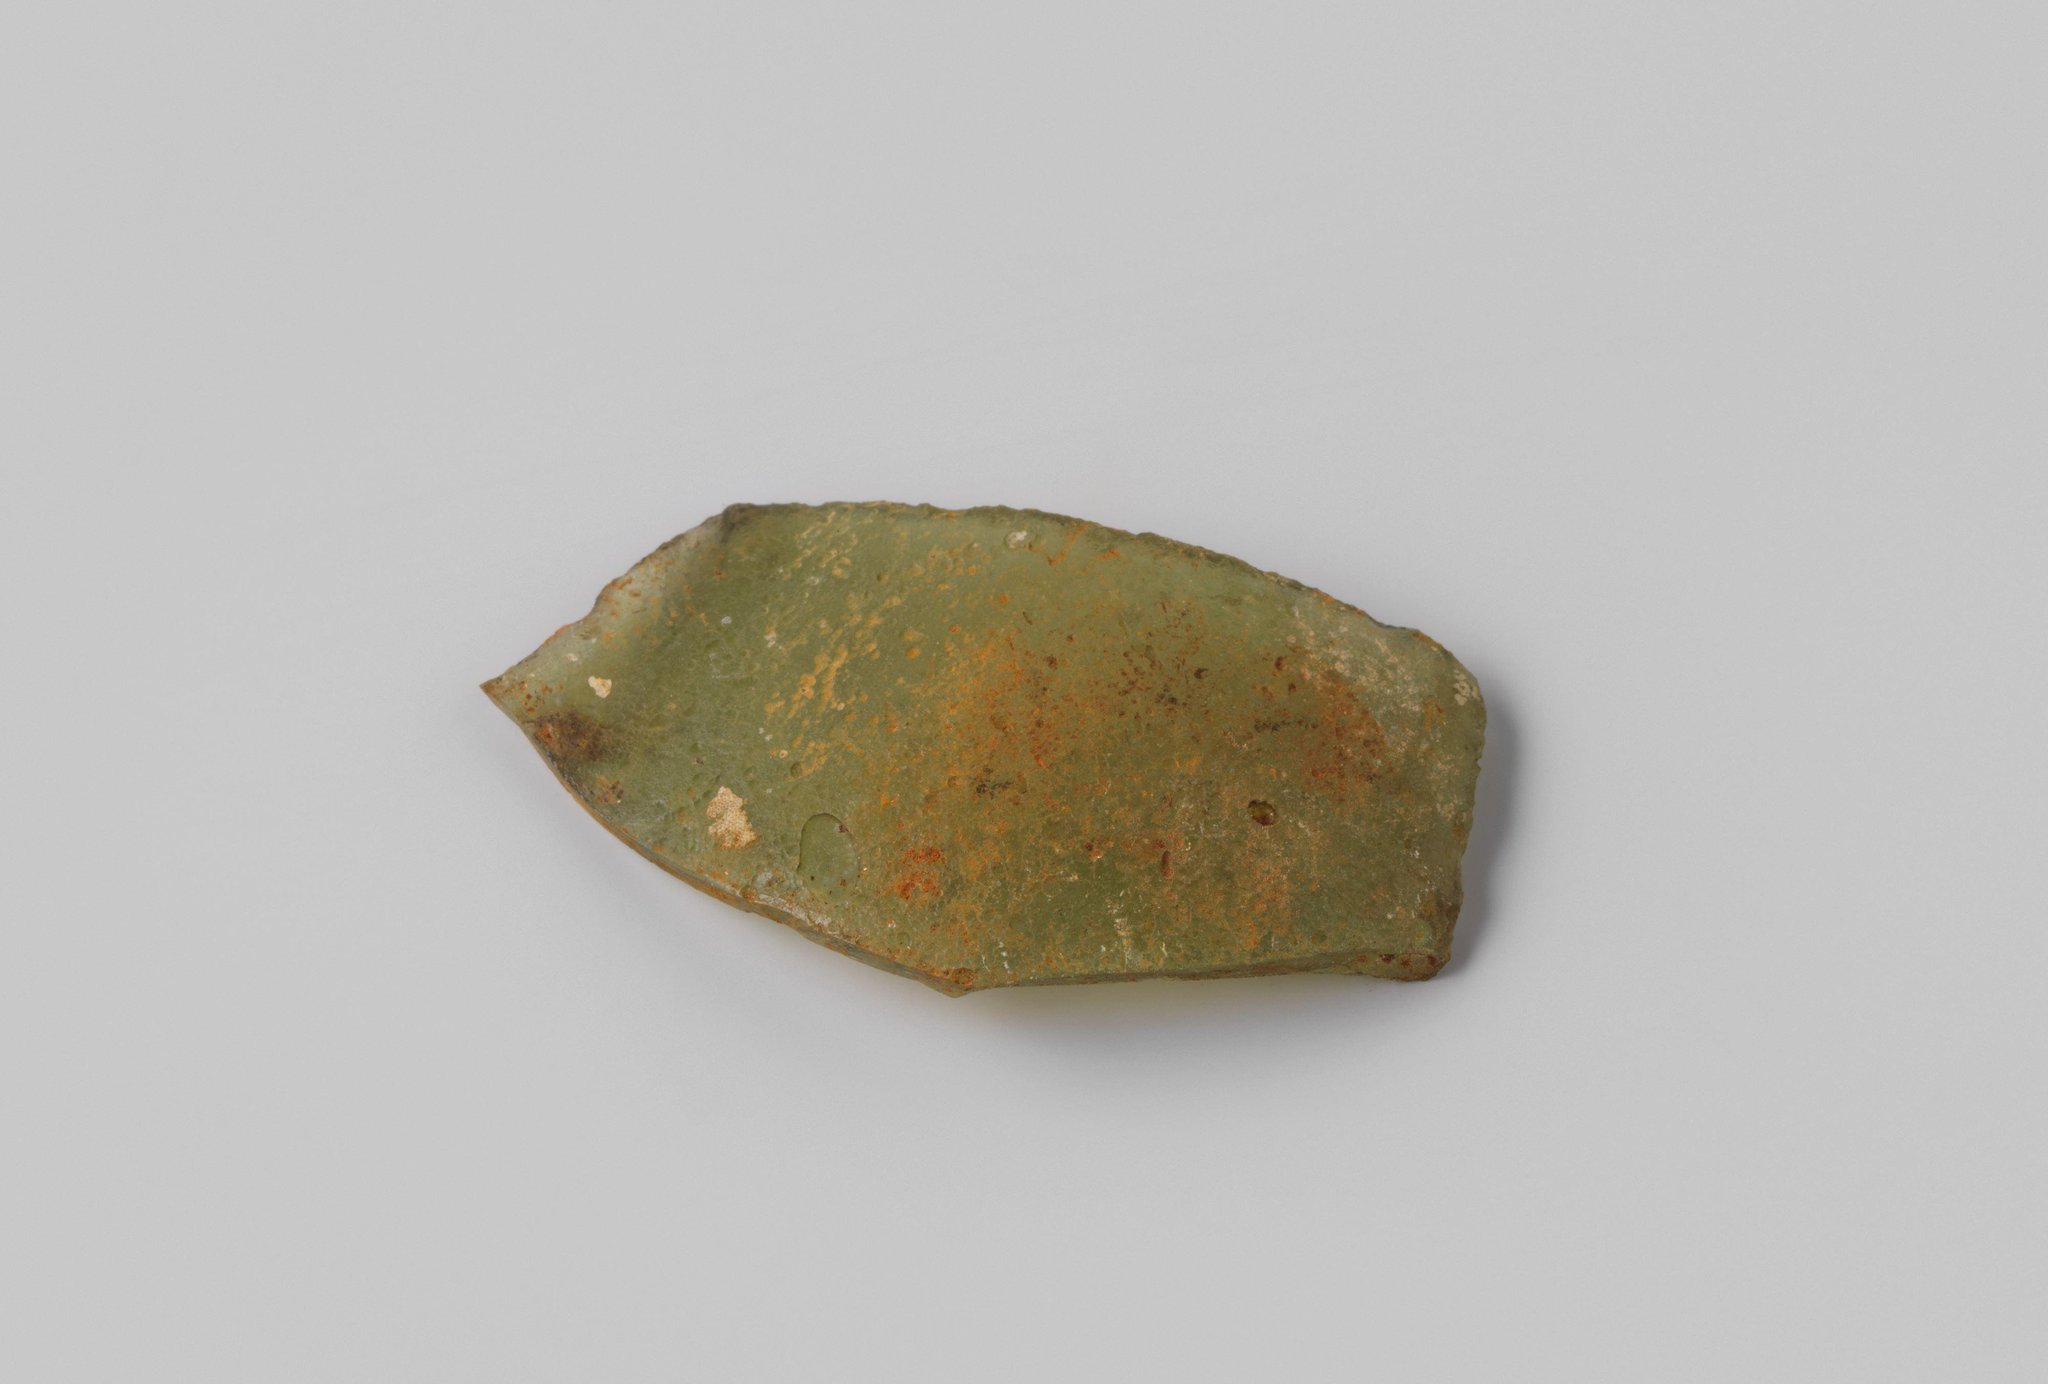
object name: sherd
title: Scherf van een wijnfles uit het wrak van de Oost-Indiëvaarder Hollandia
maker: Anonymous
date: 1700-1743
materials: glass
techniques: green glass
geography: netherlands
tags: verenigde oostindische compagnie, hollandia (schip), annet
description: Typologically not identifiable, shoulder, fragm.